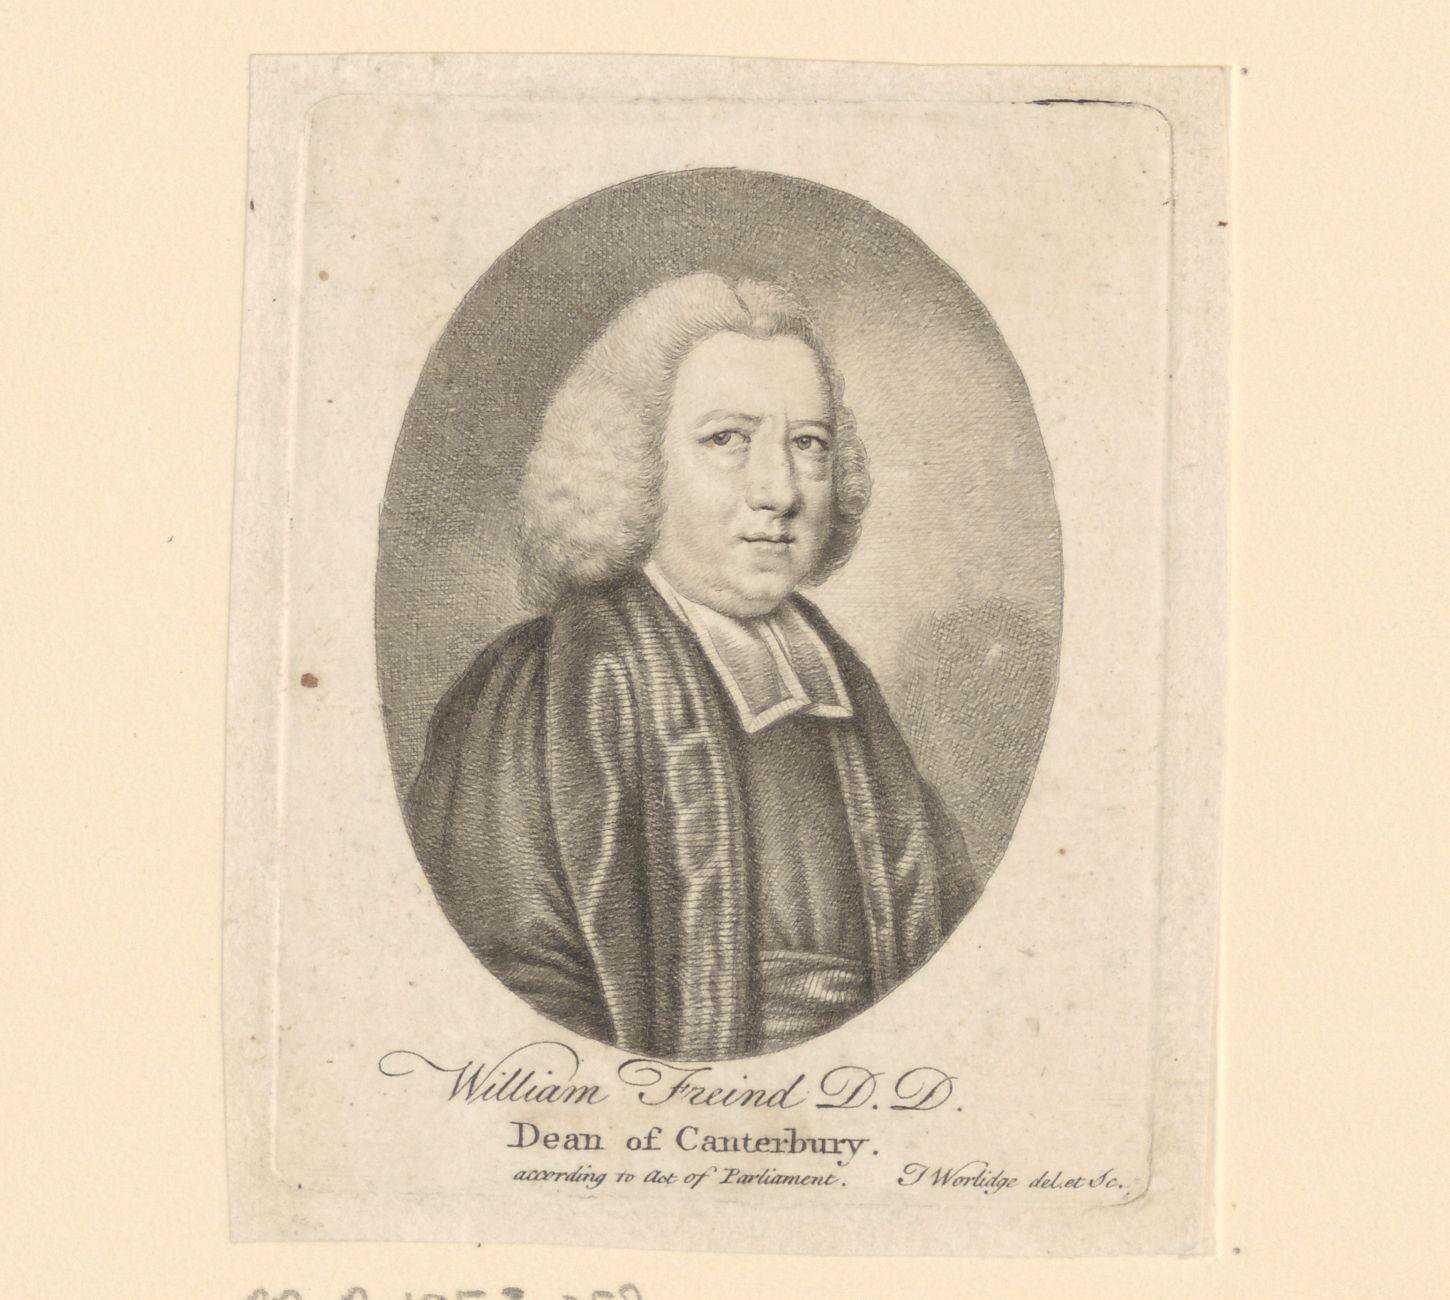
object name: print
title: Portret van William Freind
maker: thomas worlidge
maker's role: print maker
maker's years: 1700-1766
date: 1760-1766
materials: paper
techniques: drypoint, etching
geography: london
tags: clergyman, historical person (...) - historical person (...) portrayed alone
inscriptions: collector's mark: Lugt 2228, collector's mark: Lugt 2760